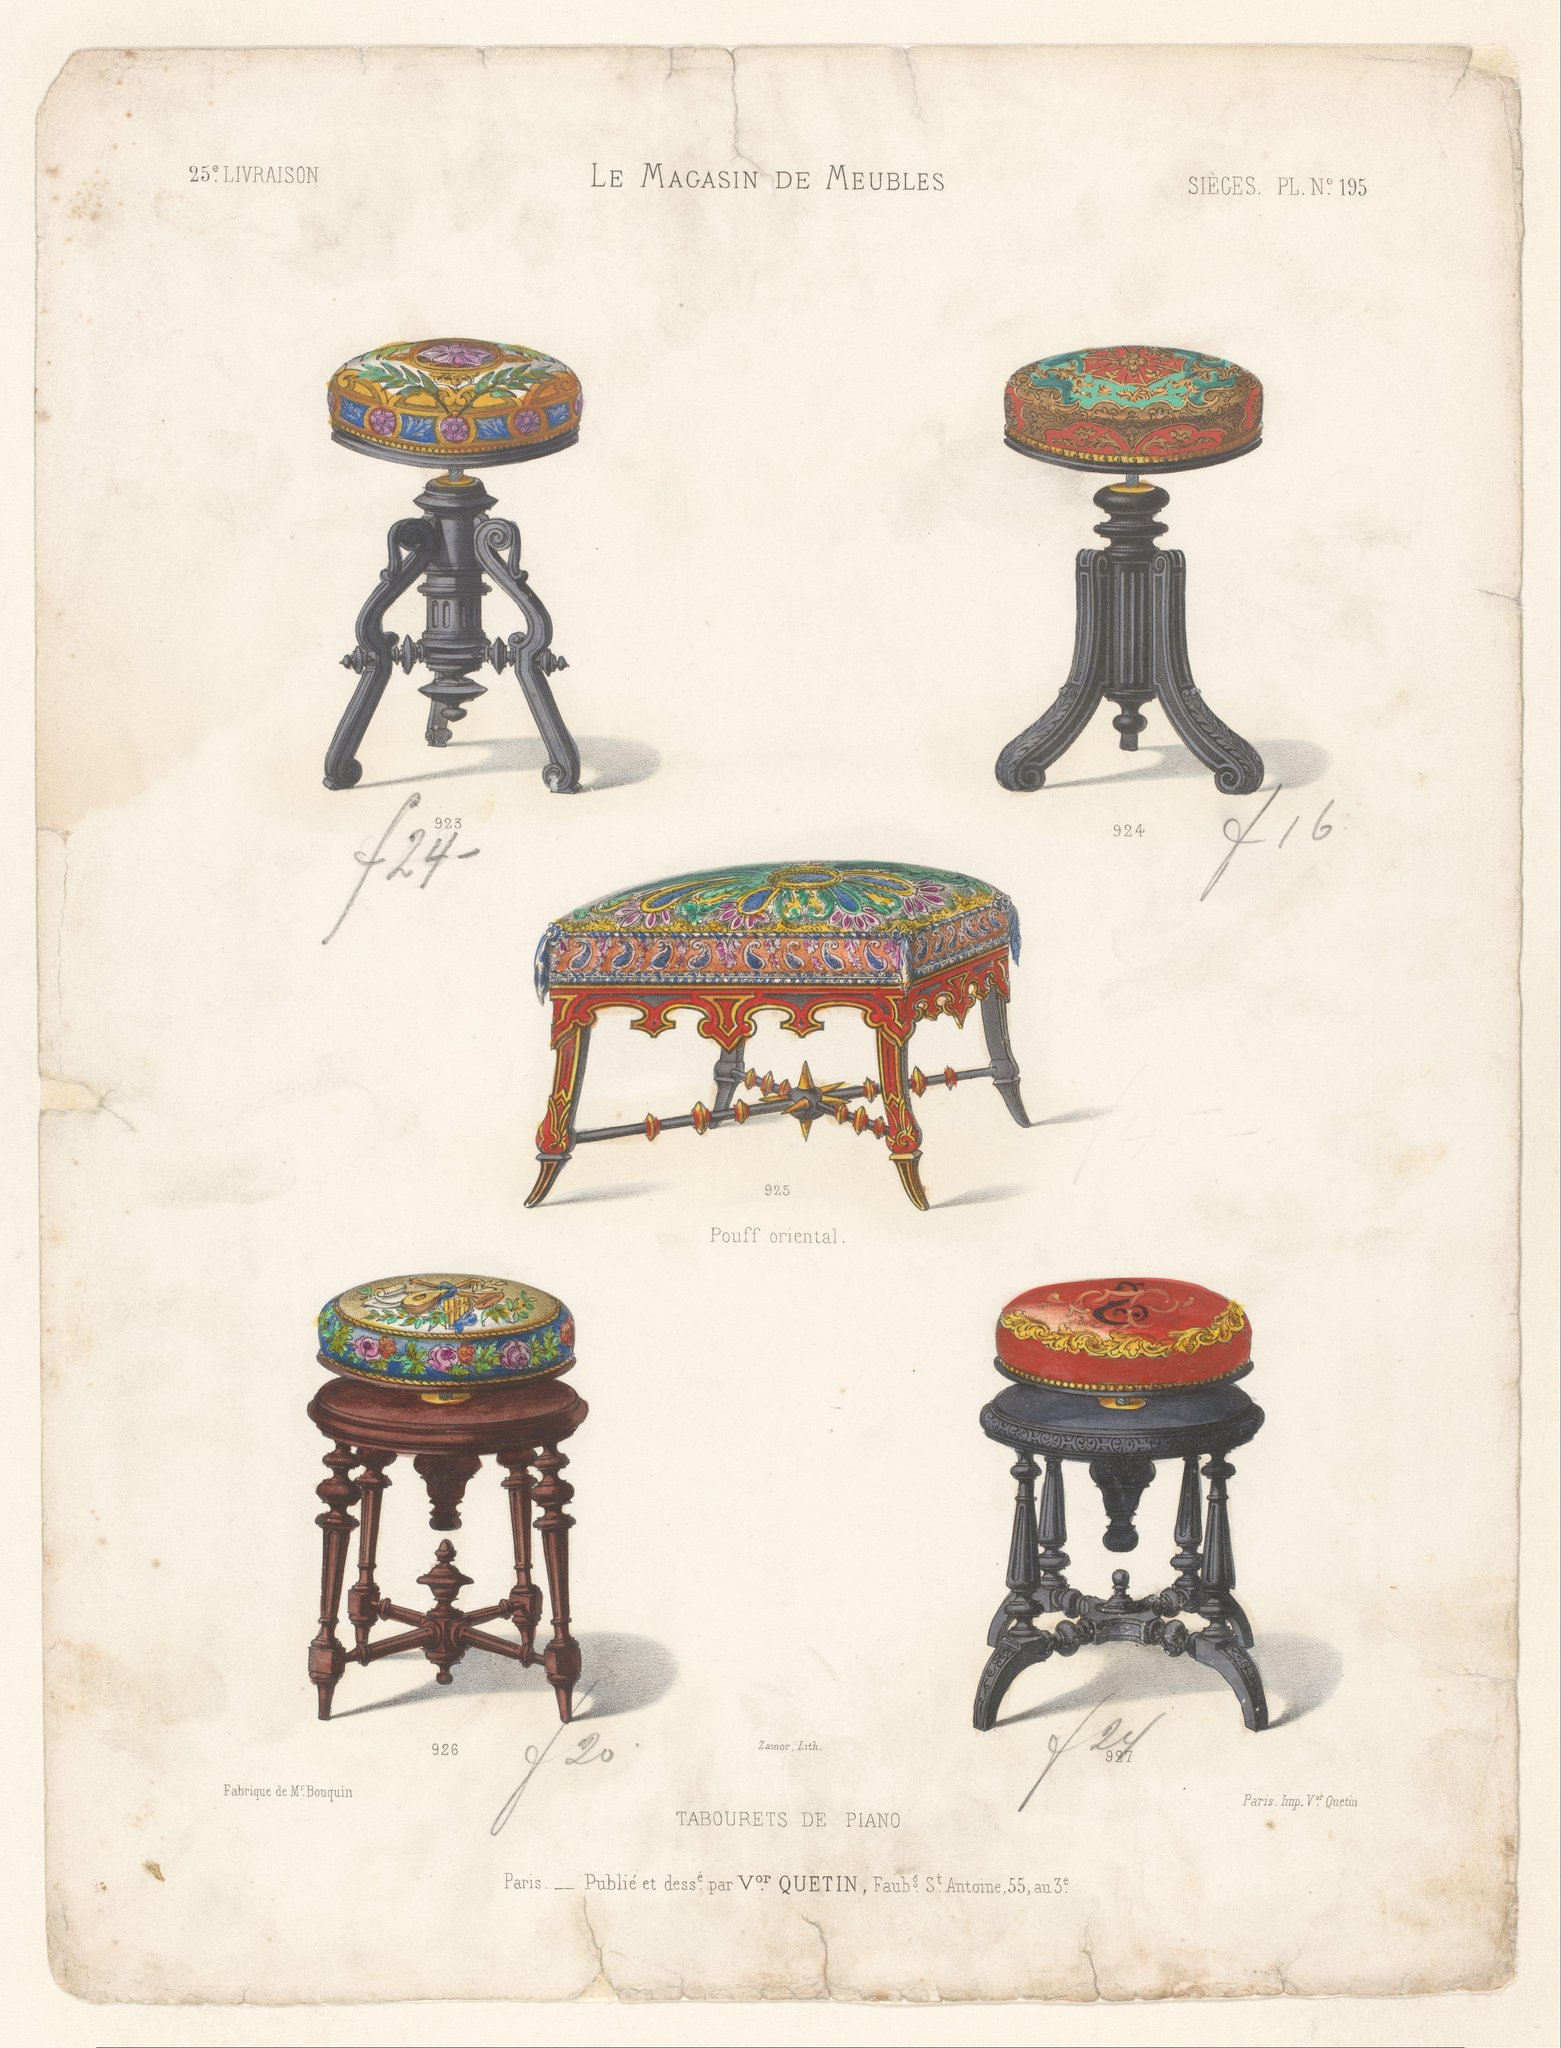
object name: print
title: Tabourets de Piano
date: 1878-1904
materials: paper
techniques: hand coloring, lithograph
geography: paris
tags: stool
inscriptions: annotation: ‘f 24,-, f 16,-, f 20,-, f 24,-’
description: Nummers 923-927. Prent uit 25e Livraison.